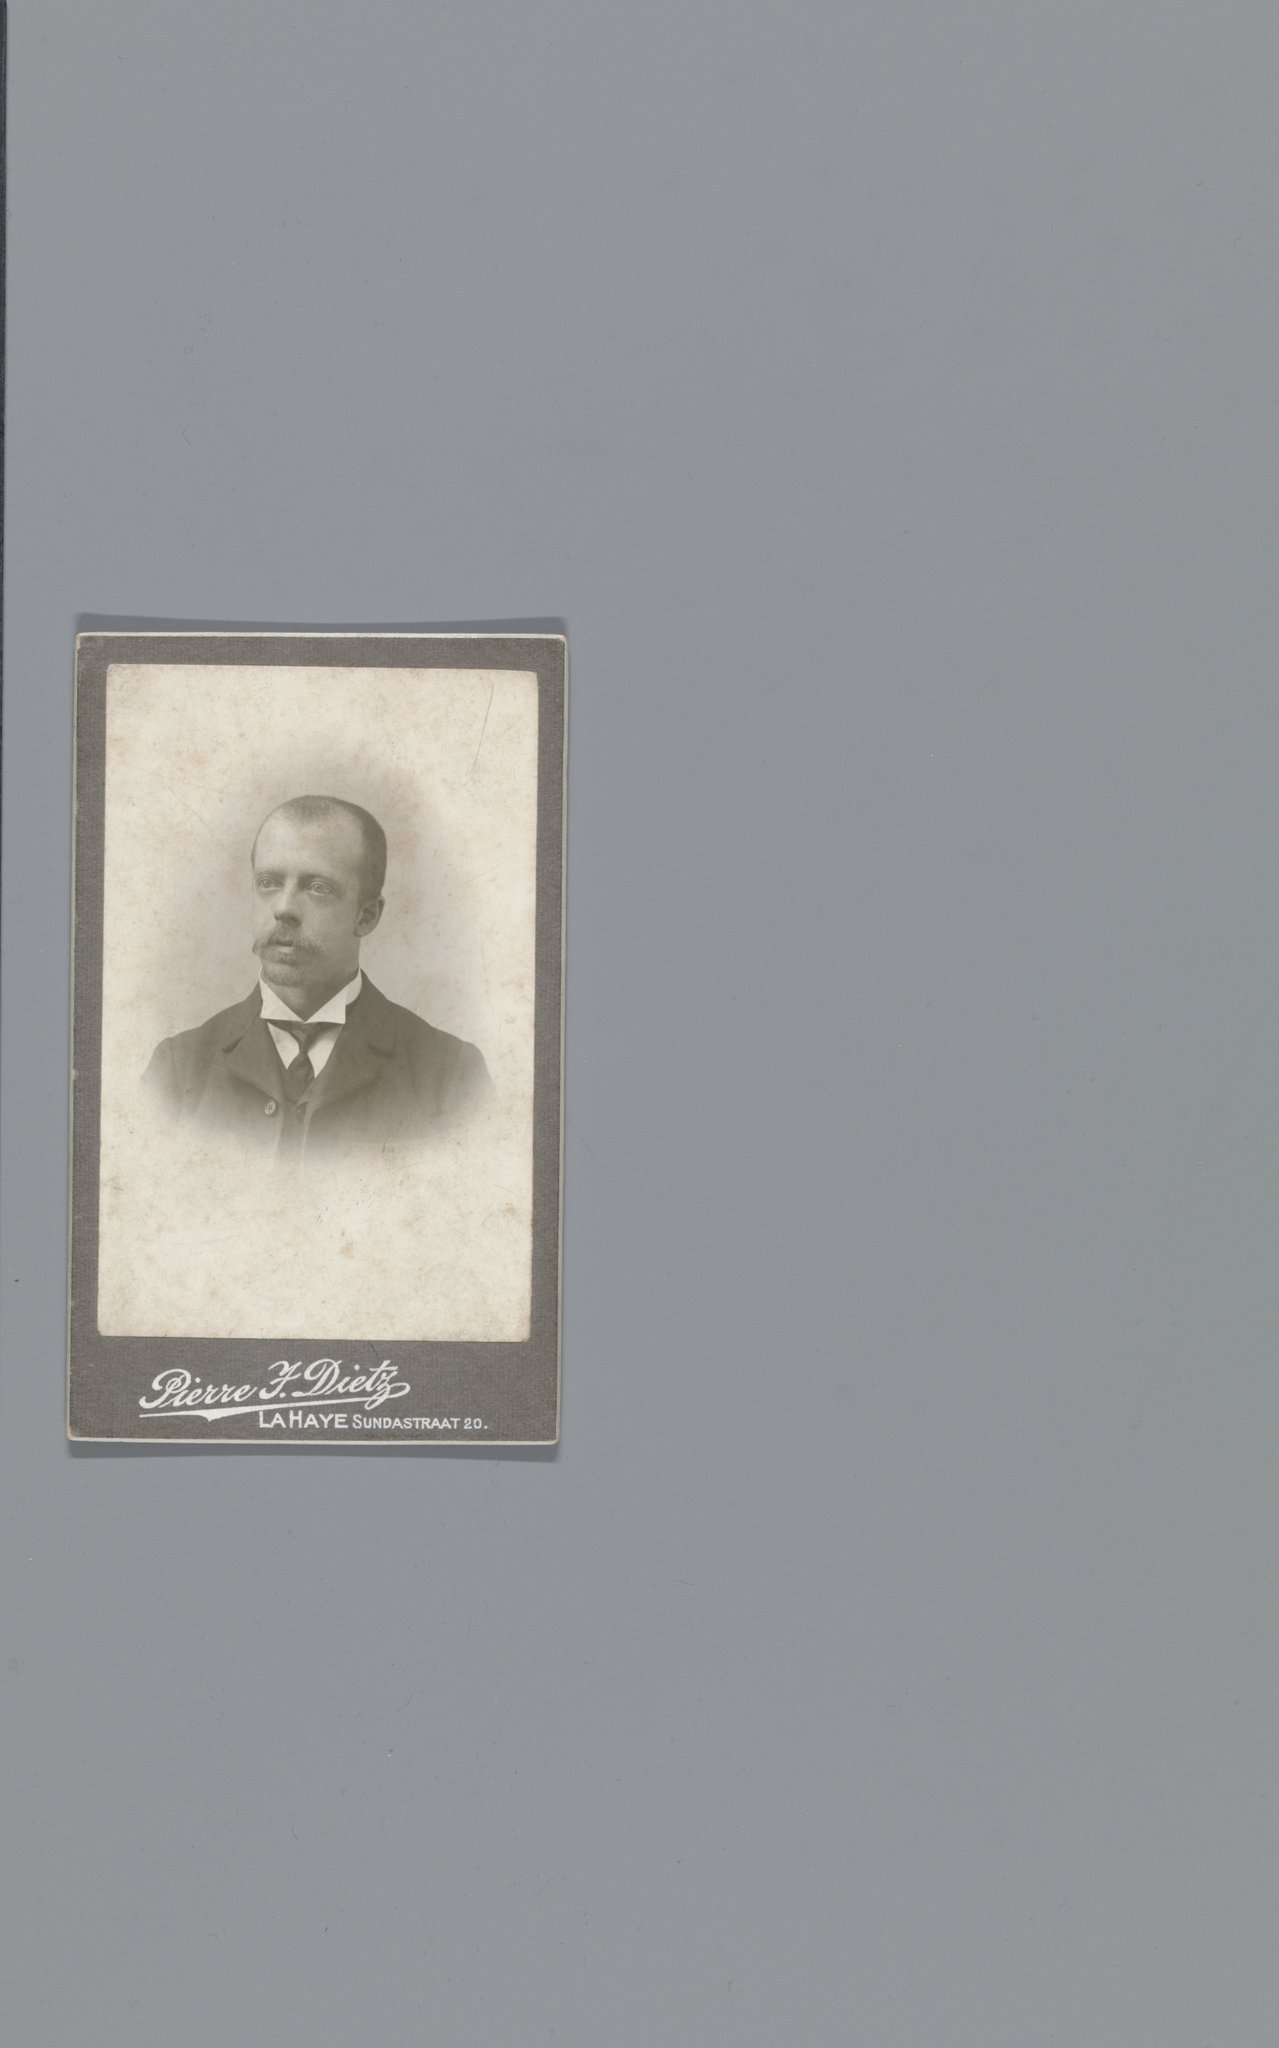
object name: carte de visite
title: Chap van Deventer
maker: pierre j. dietz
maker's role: fotograaf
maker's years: 1879-1959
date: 1860-1915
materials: cardboard, paper, photographic support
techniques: matte daylight collodion silver print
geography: netherlands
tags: dordrecht, amsterdam, chap van deventer